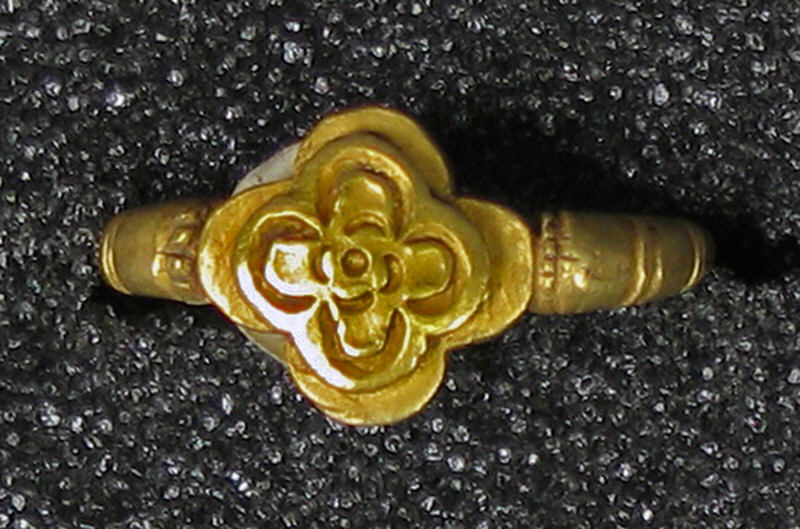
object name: ring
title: Ring with Stepped Quatrefoil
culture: indonesian, central java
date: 701-1200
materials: gold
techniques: casting